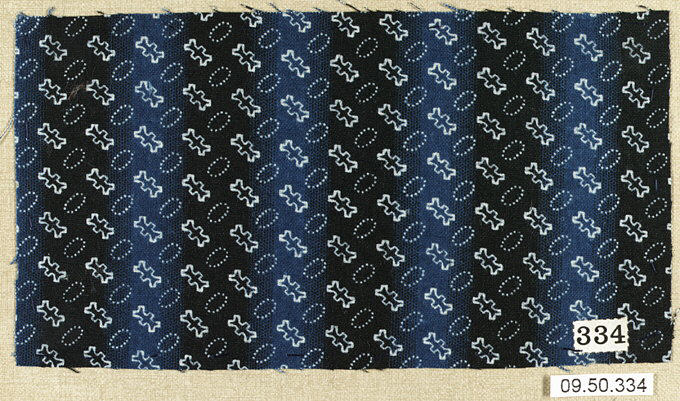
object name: piece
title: Piece (one of 116)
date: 1801-1900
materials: cotton